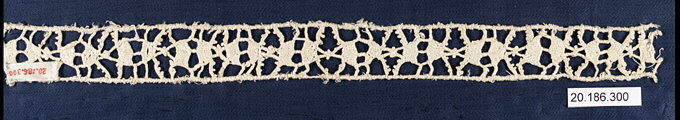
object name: insertion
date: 1601-1700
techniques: lace